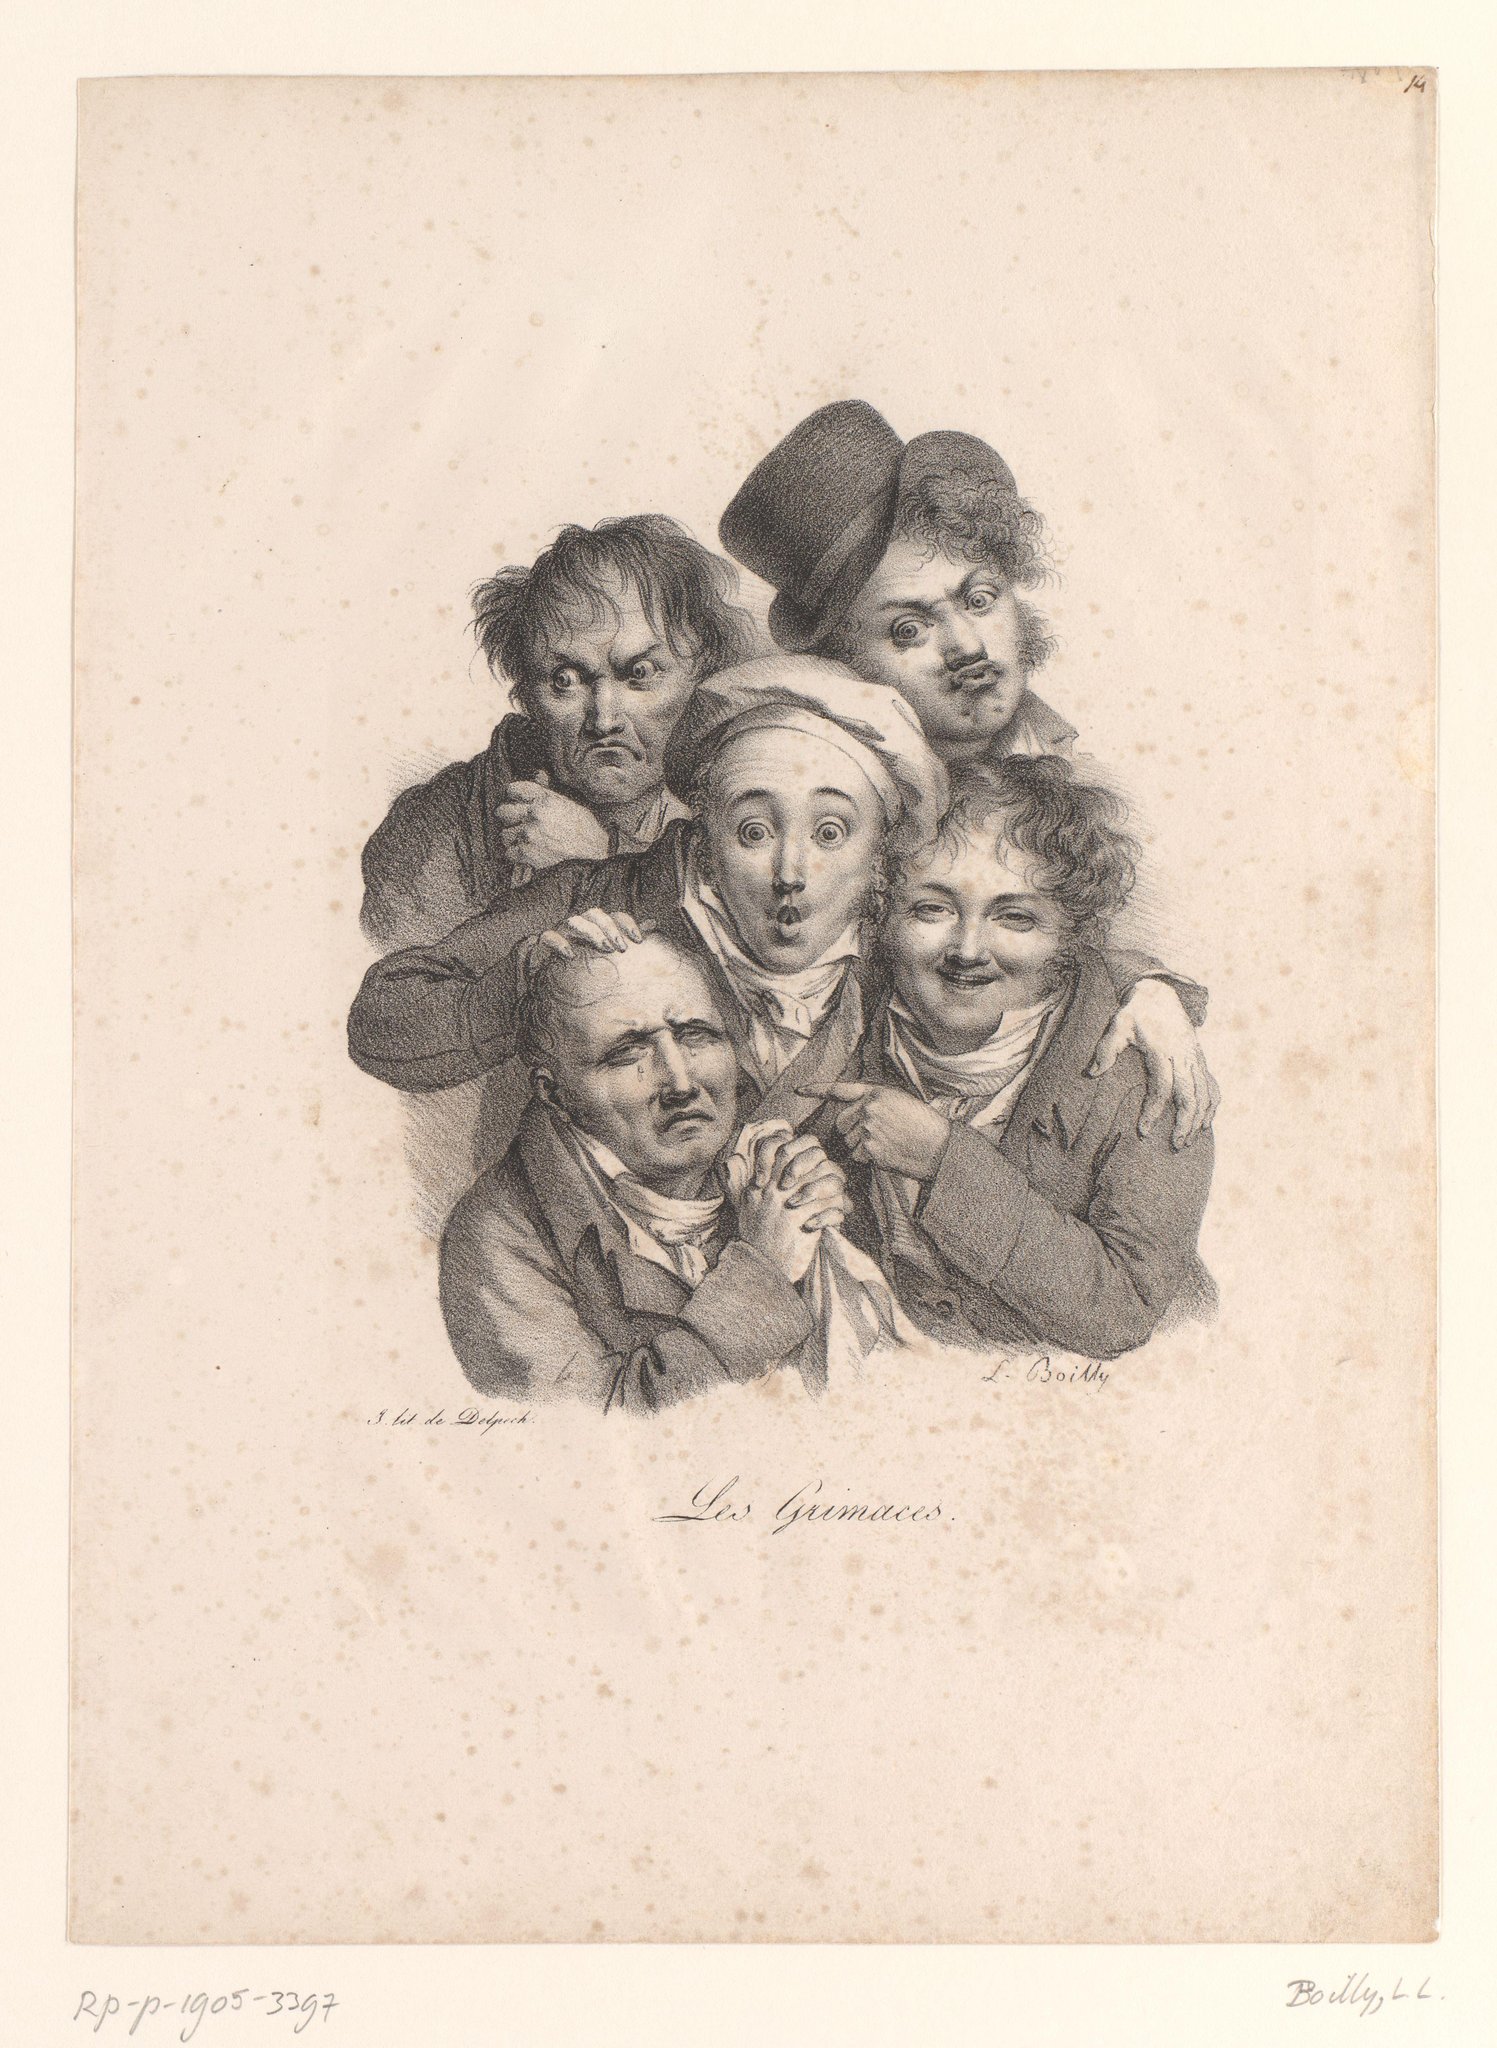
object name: print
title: Gezichten met een grimas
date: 1823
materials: paper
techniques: lithograph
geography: paris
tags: caricatures (human types), morphology of facial expression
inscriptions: collector's mark: Lugt 2228a